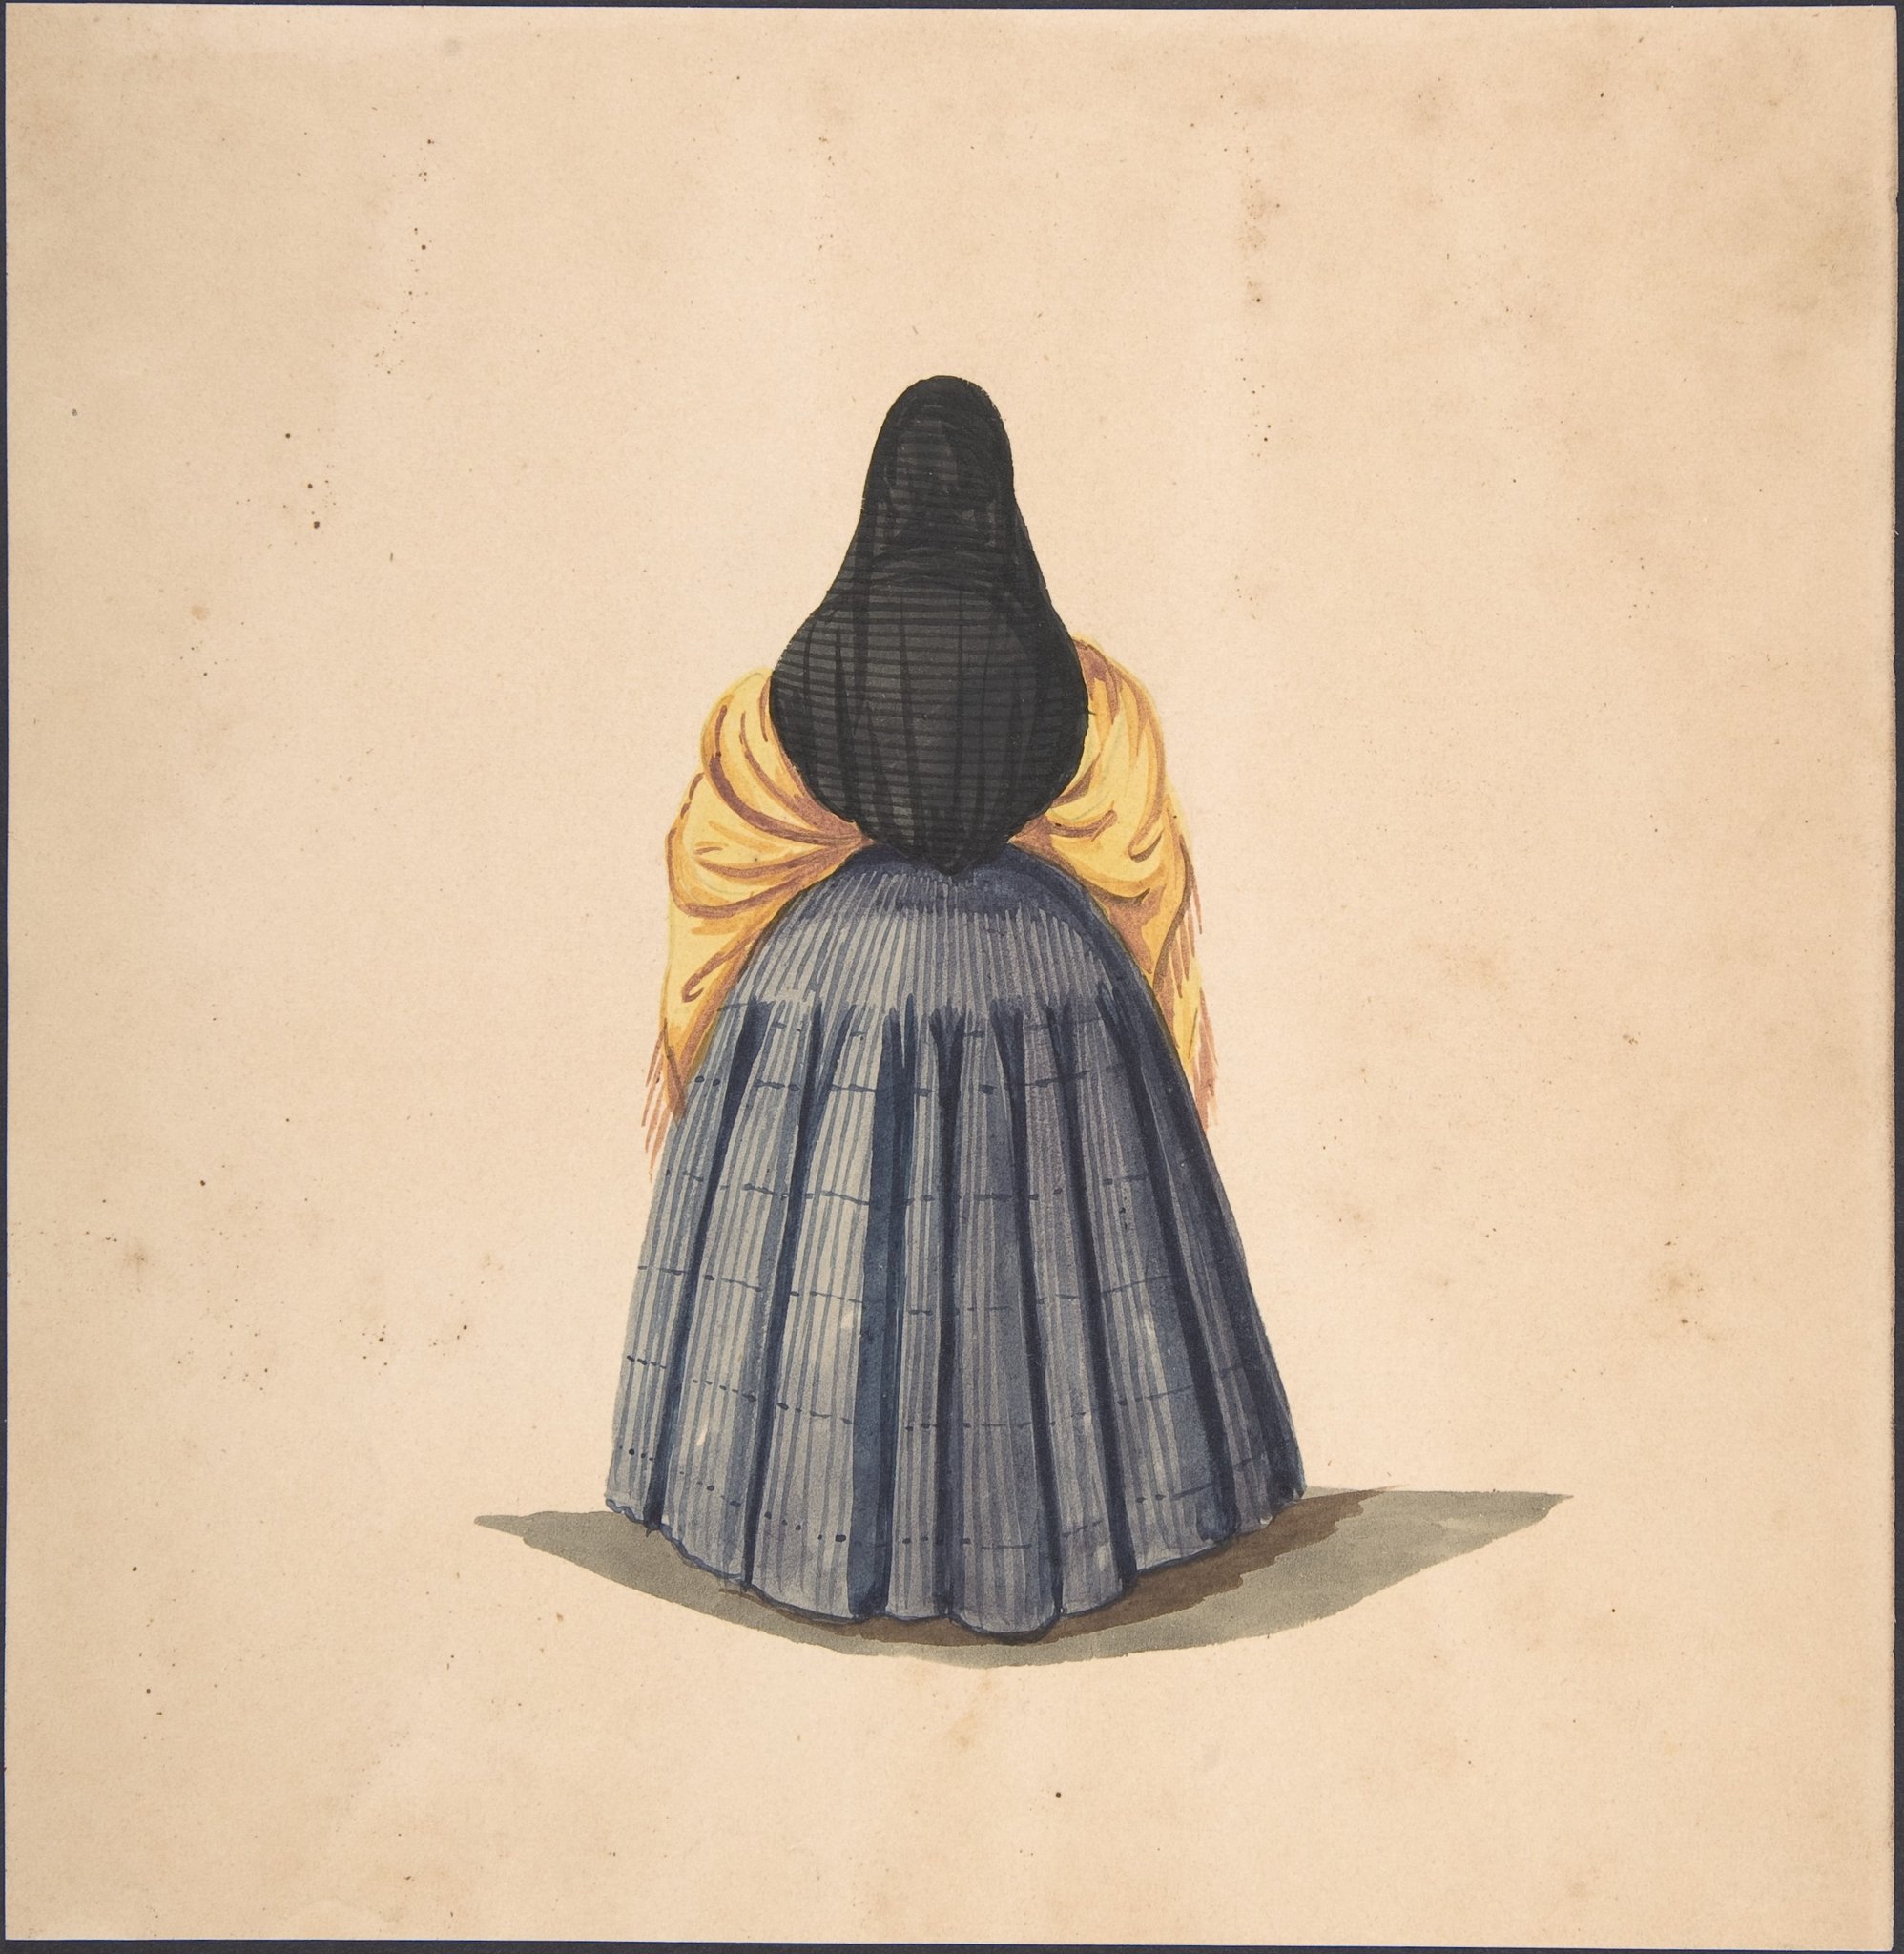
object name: drawing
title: A Standing Woman, Seen from the Back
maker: anonymous, peruvian, 19th century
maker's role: artist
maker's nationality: peruvian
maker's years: 1800-1900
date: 1840-1850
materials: ink, watercolor, paper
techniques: brush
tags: women